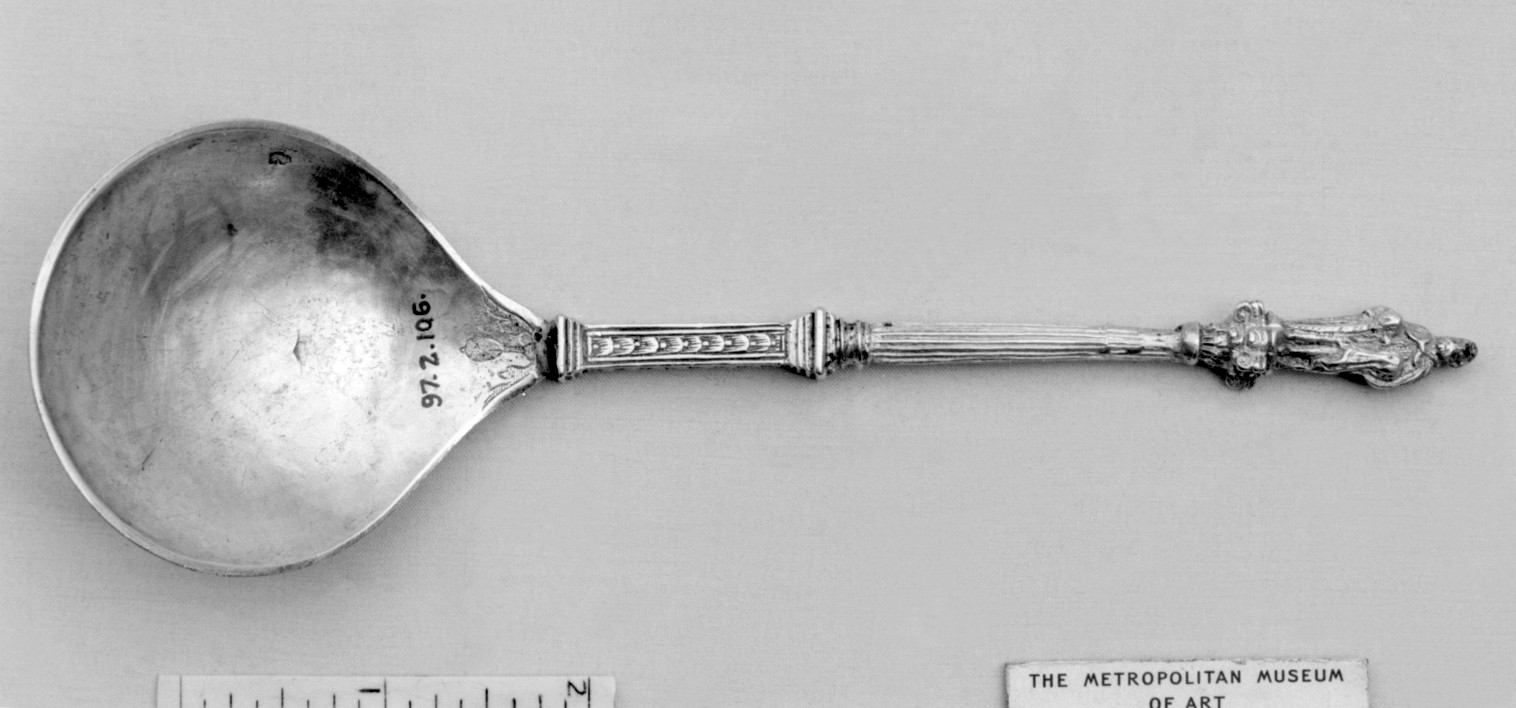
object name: apostle spoon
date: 1567-1633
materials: gilt, silver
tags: apostles